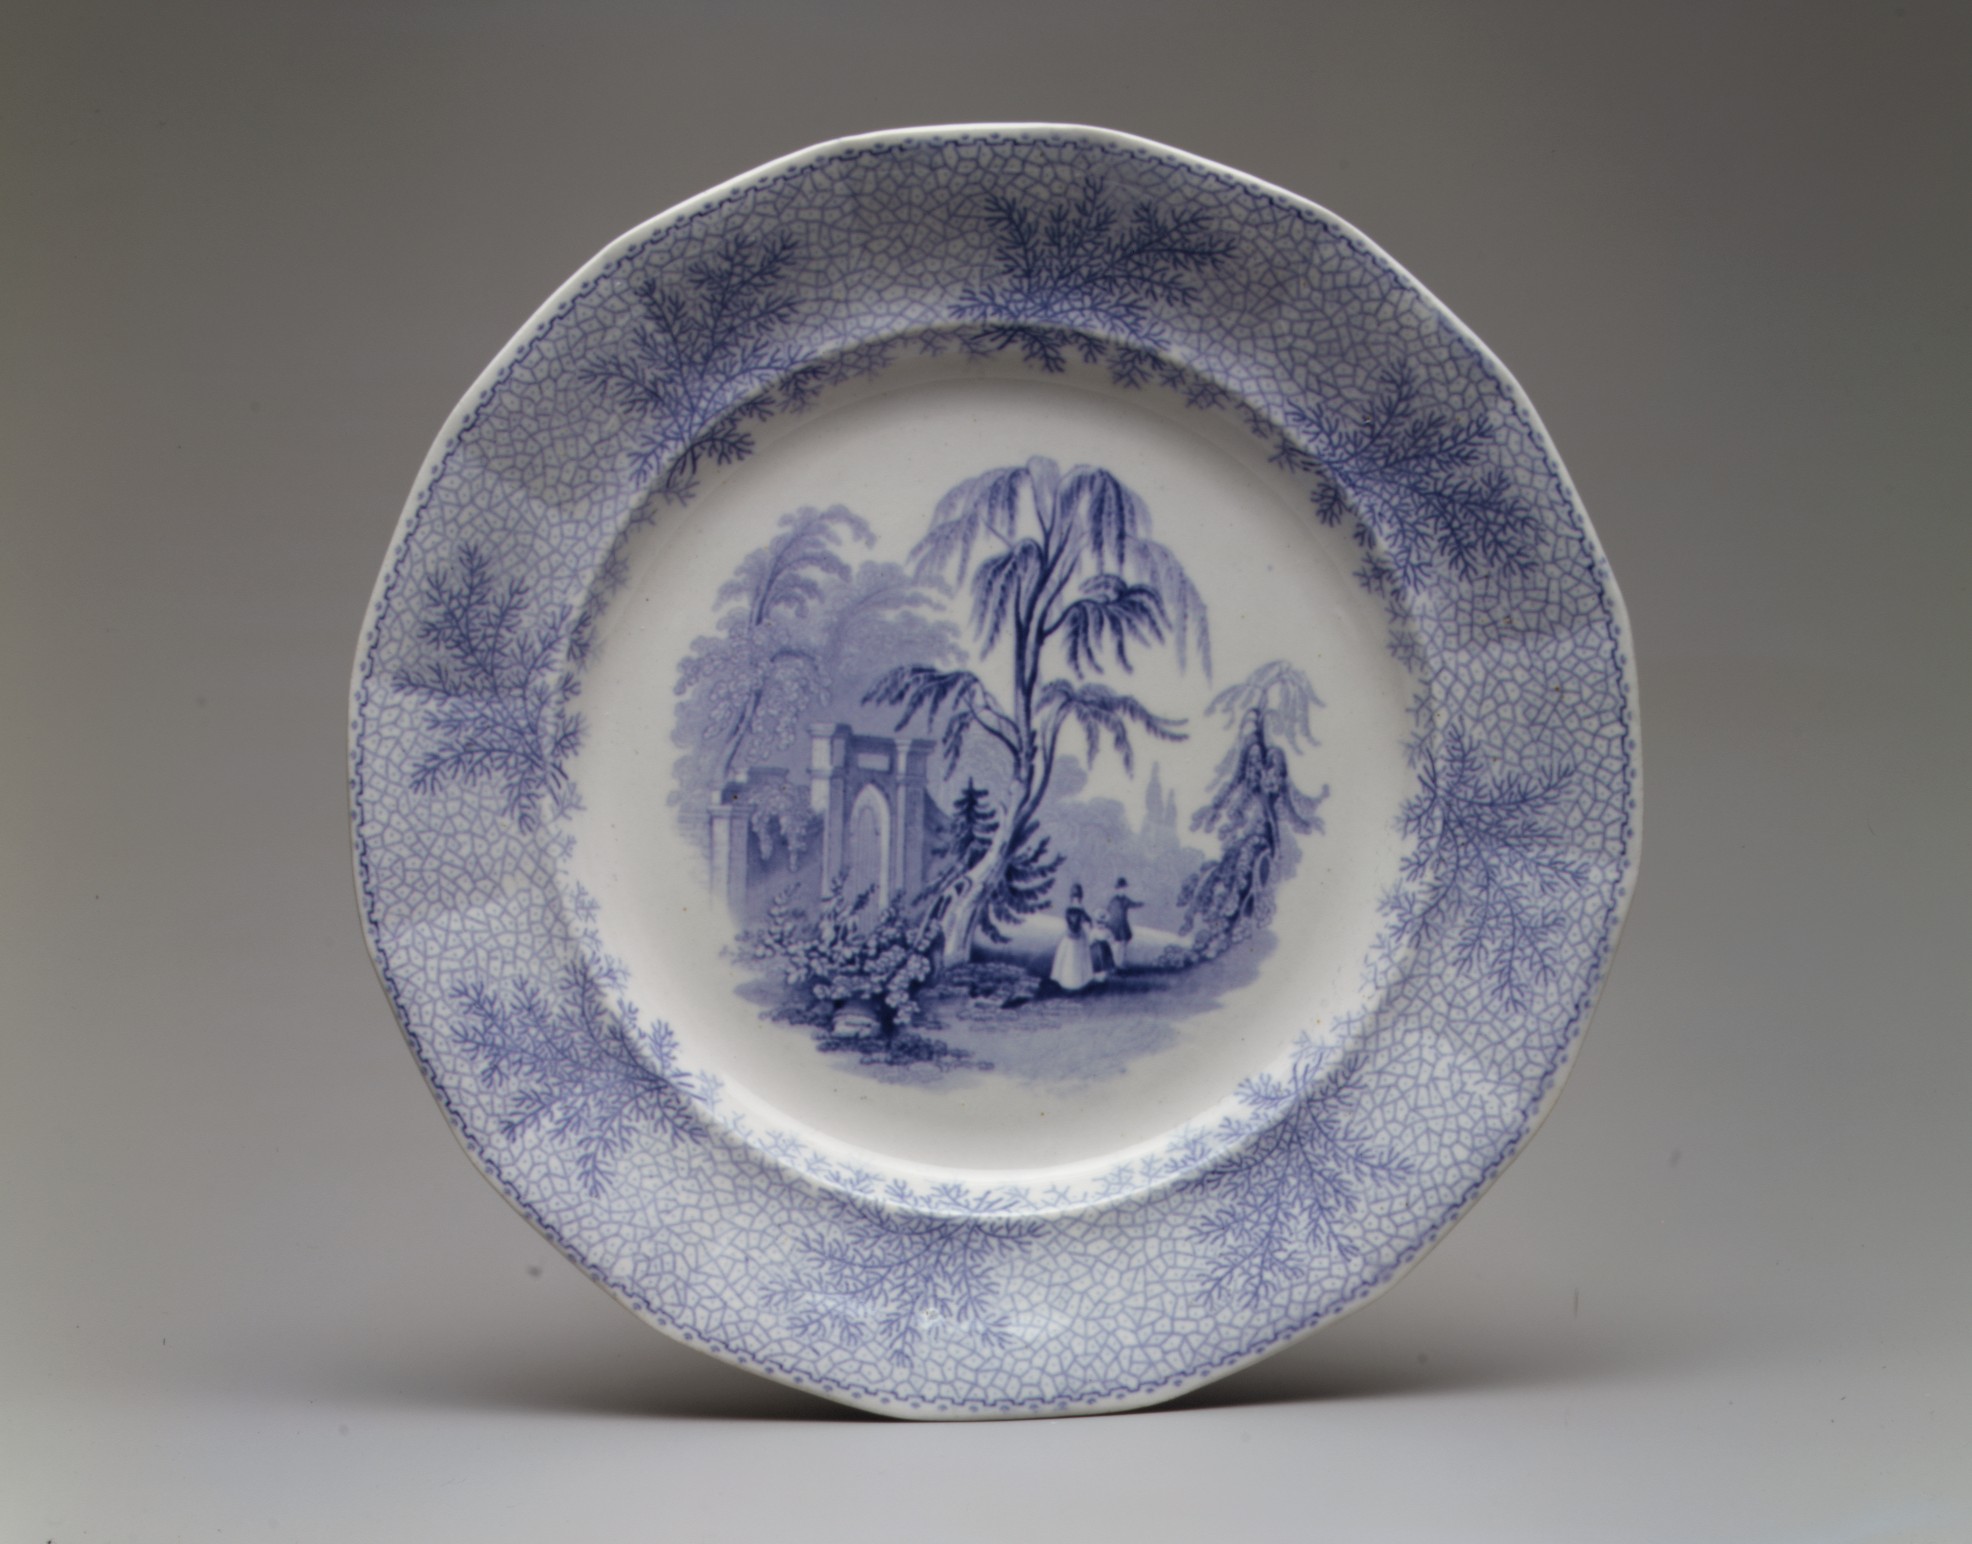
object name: plate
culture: british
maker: william ridgway, son & co.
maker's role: maker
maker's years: 1833-1848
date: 1844-1848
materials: earthenware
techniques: transfer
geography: england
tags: men,women,trees